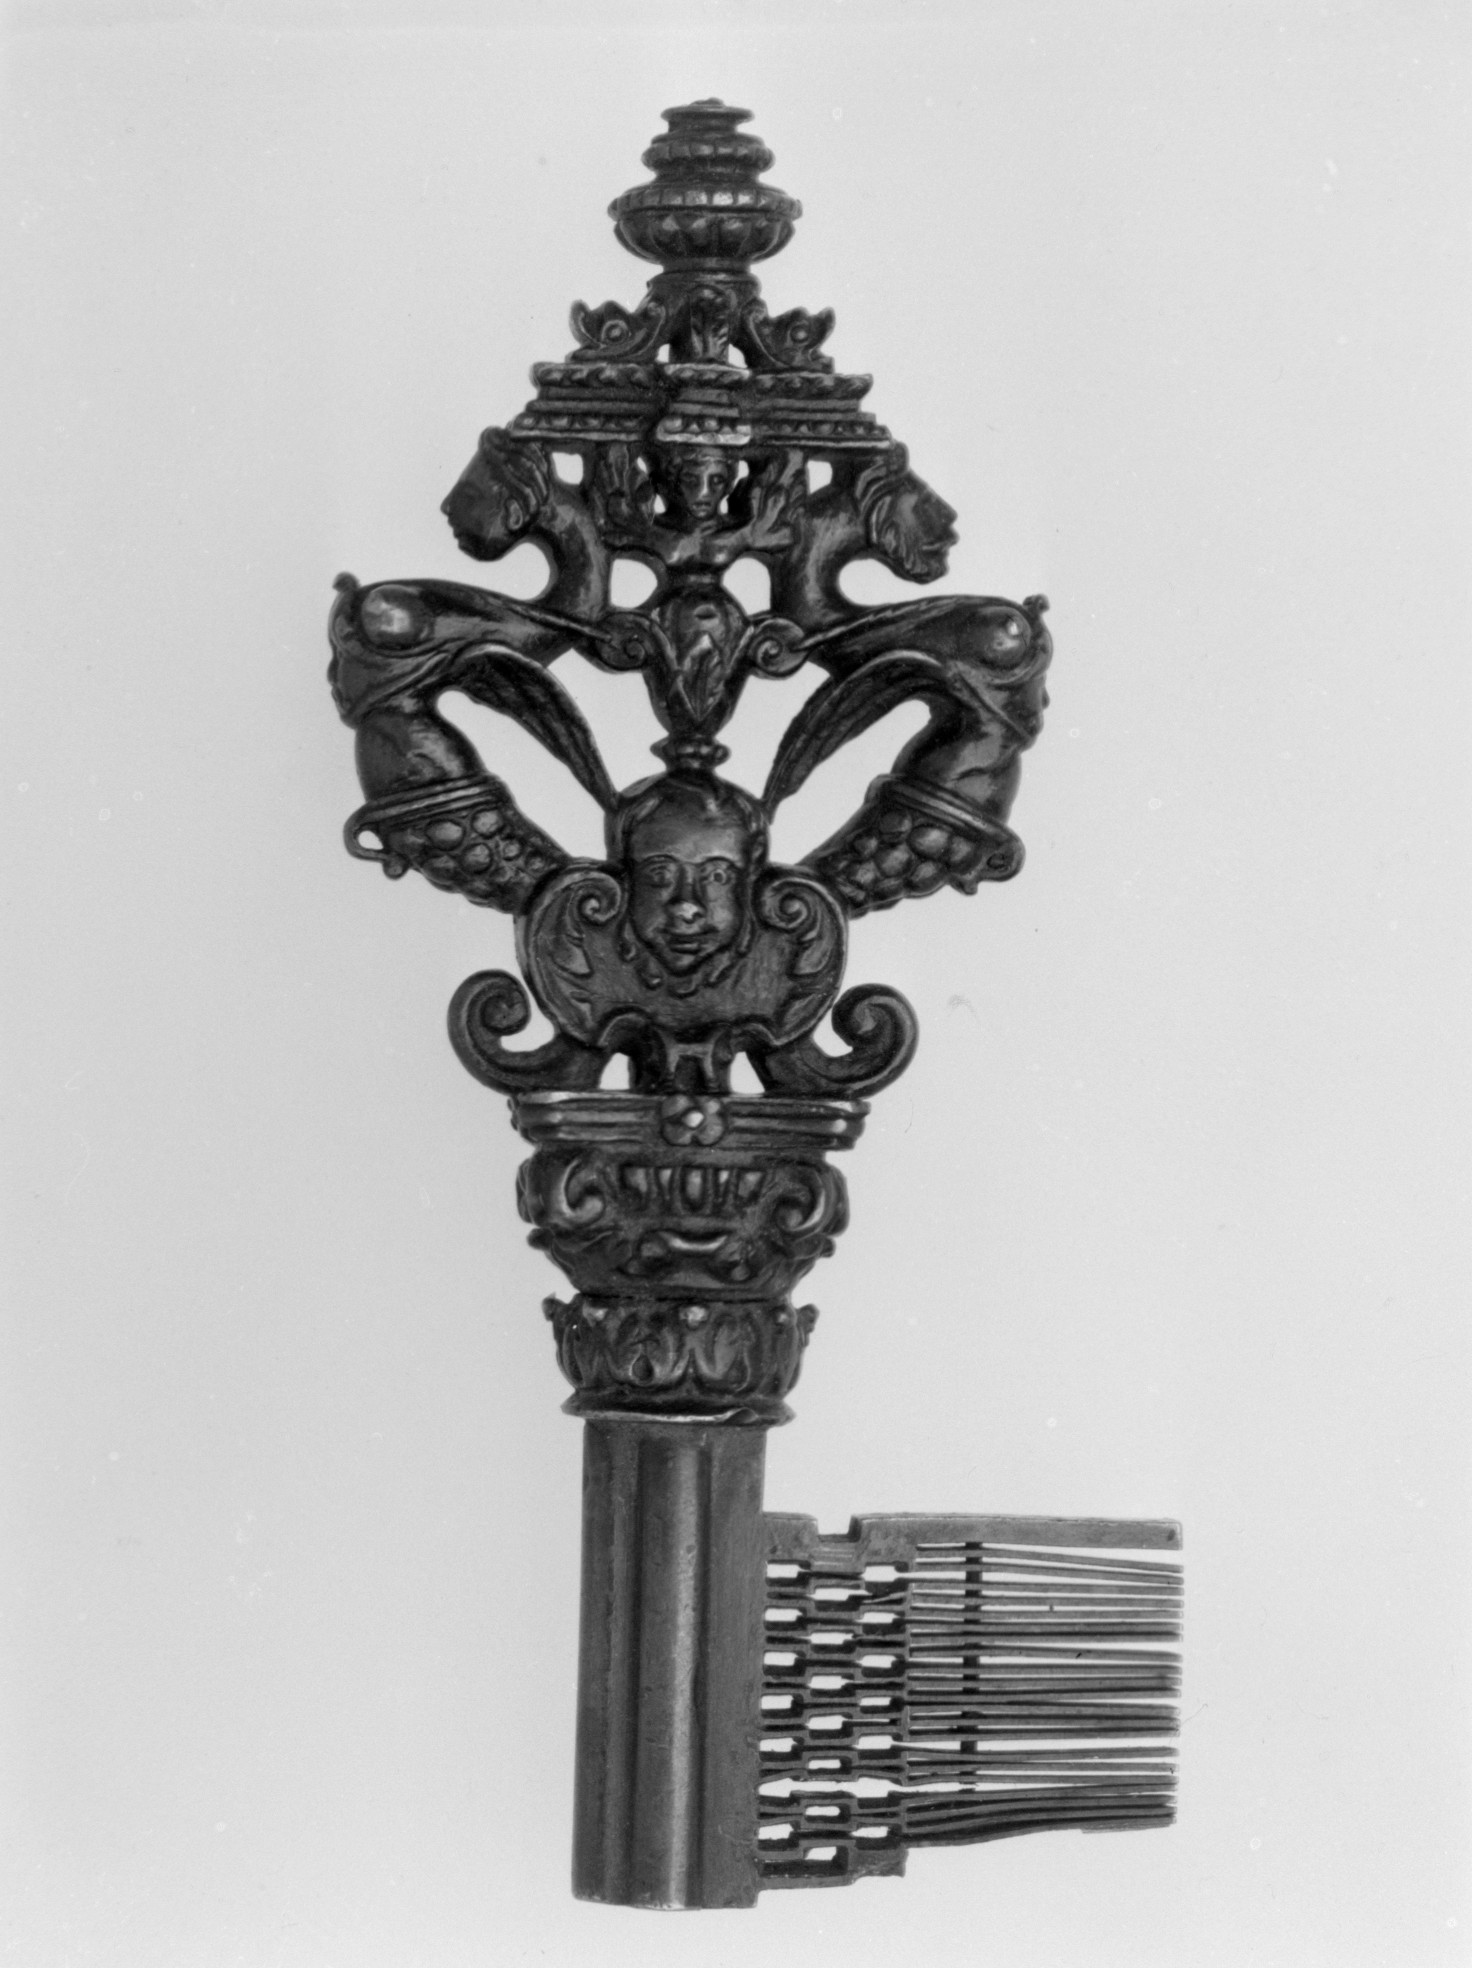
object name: key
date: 1801-1900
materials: bronze